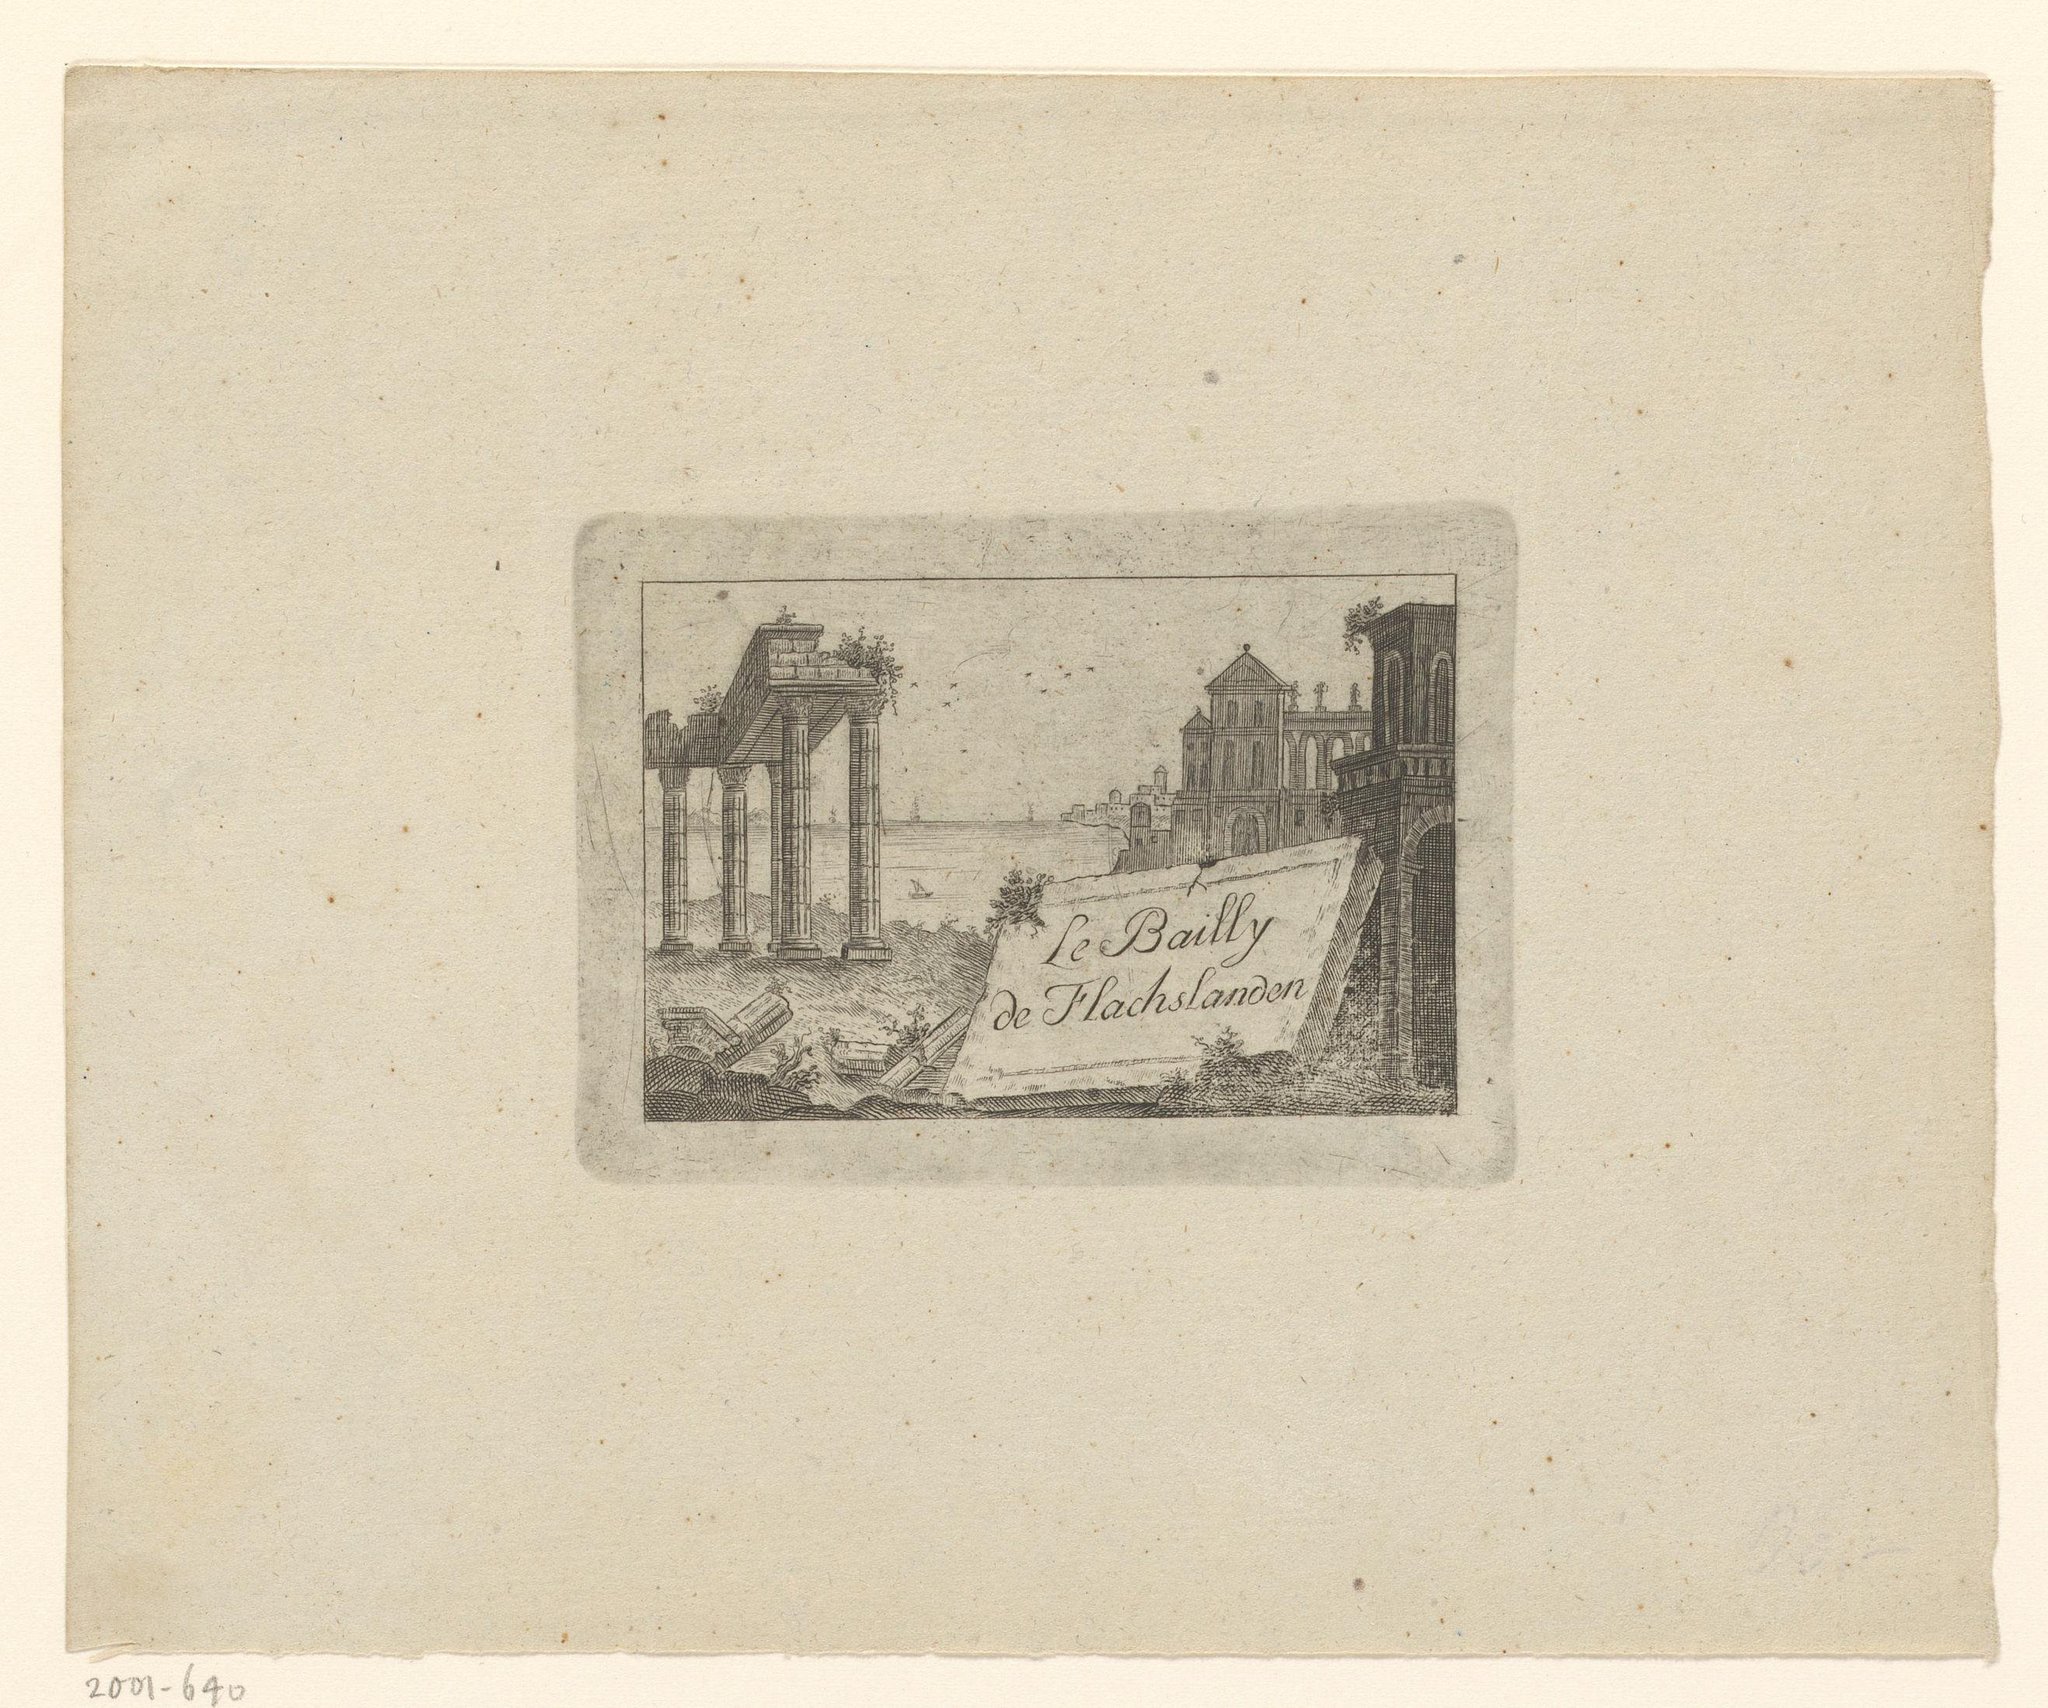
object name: print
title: Visitekaartje Le Bailly de Flachslanden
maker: Anonymous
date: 1740-1825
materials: paper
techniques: etching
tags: politician, landscape with ruins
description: Landschap met ruïne van antieke tempel en kasteel. Op de voorgrond een schuinstaande steen waarop de tekst 'Le Bailly de Flachslanden'.